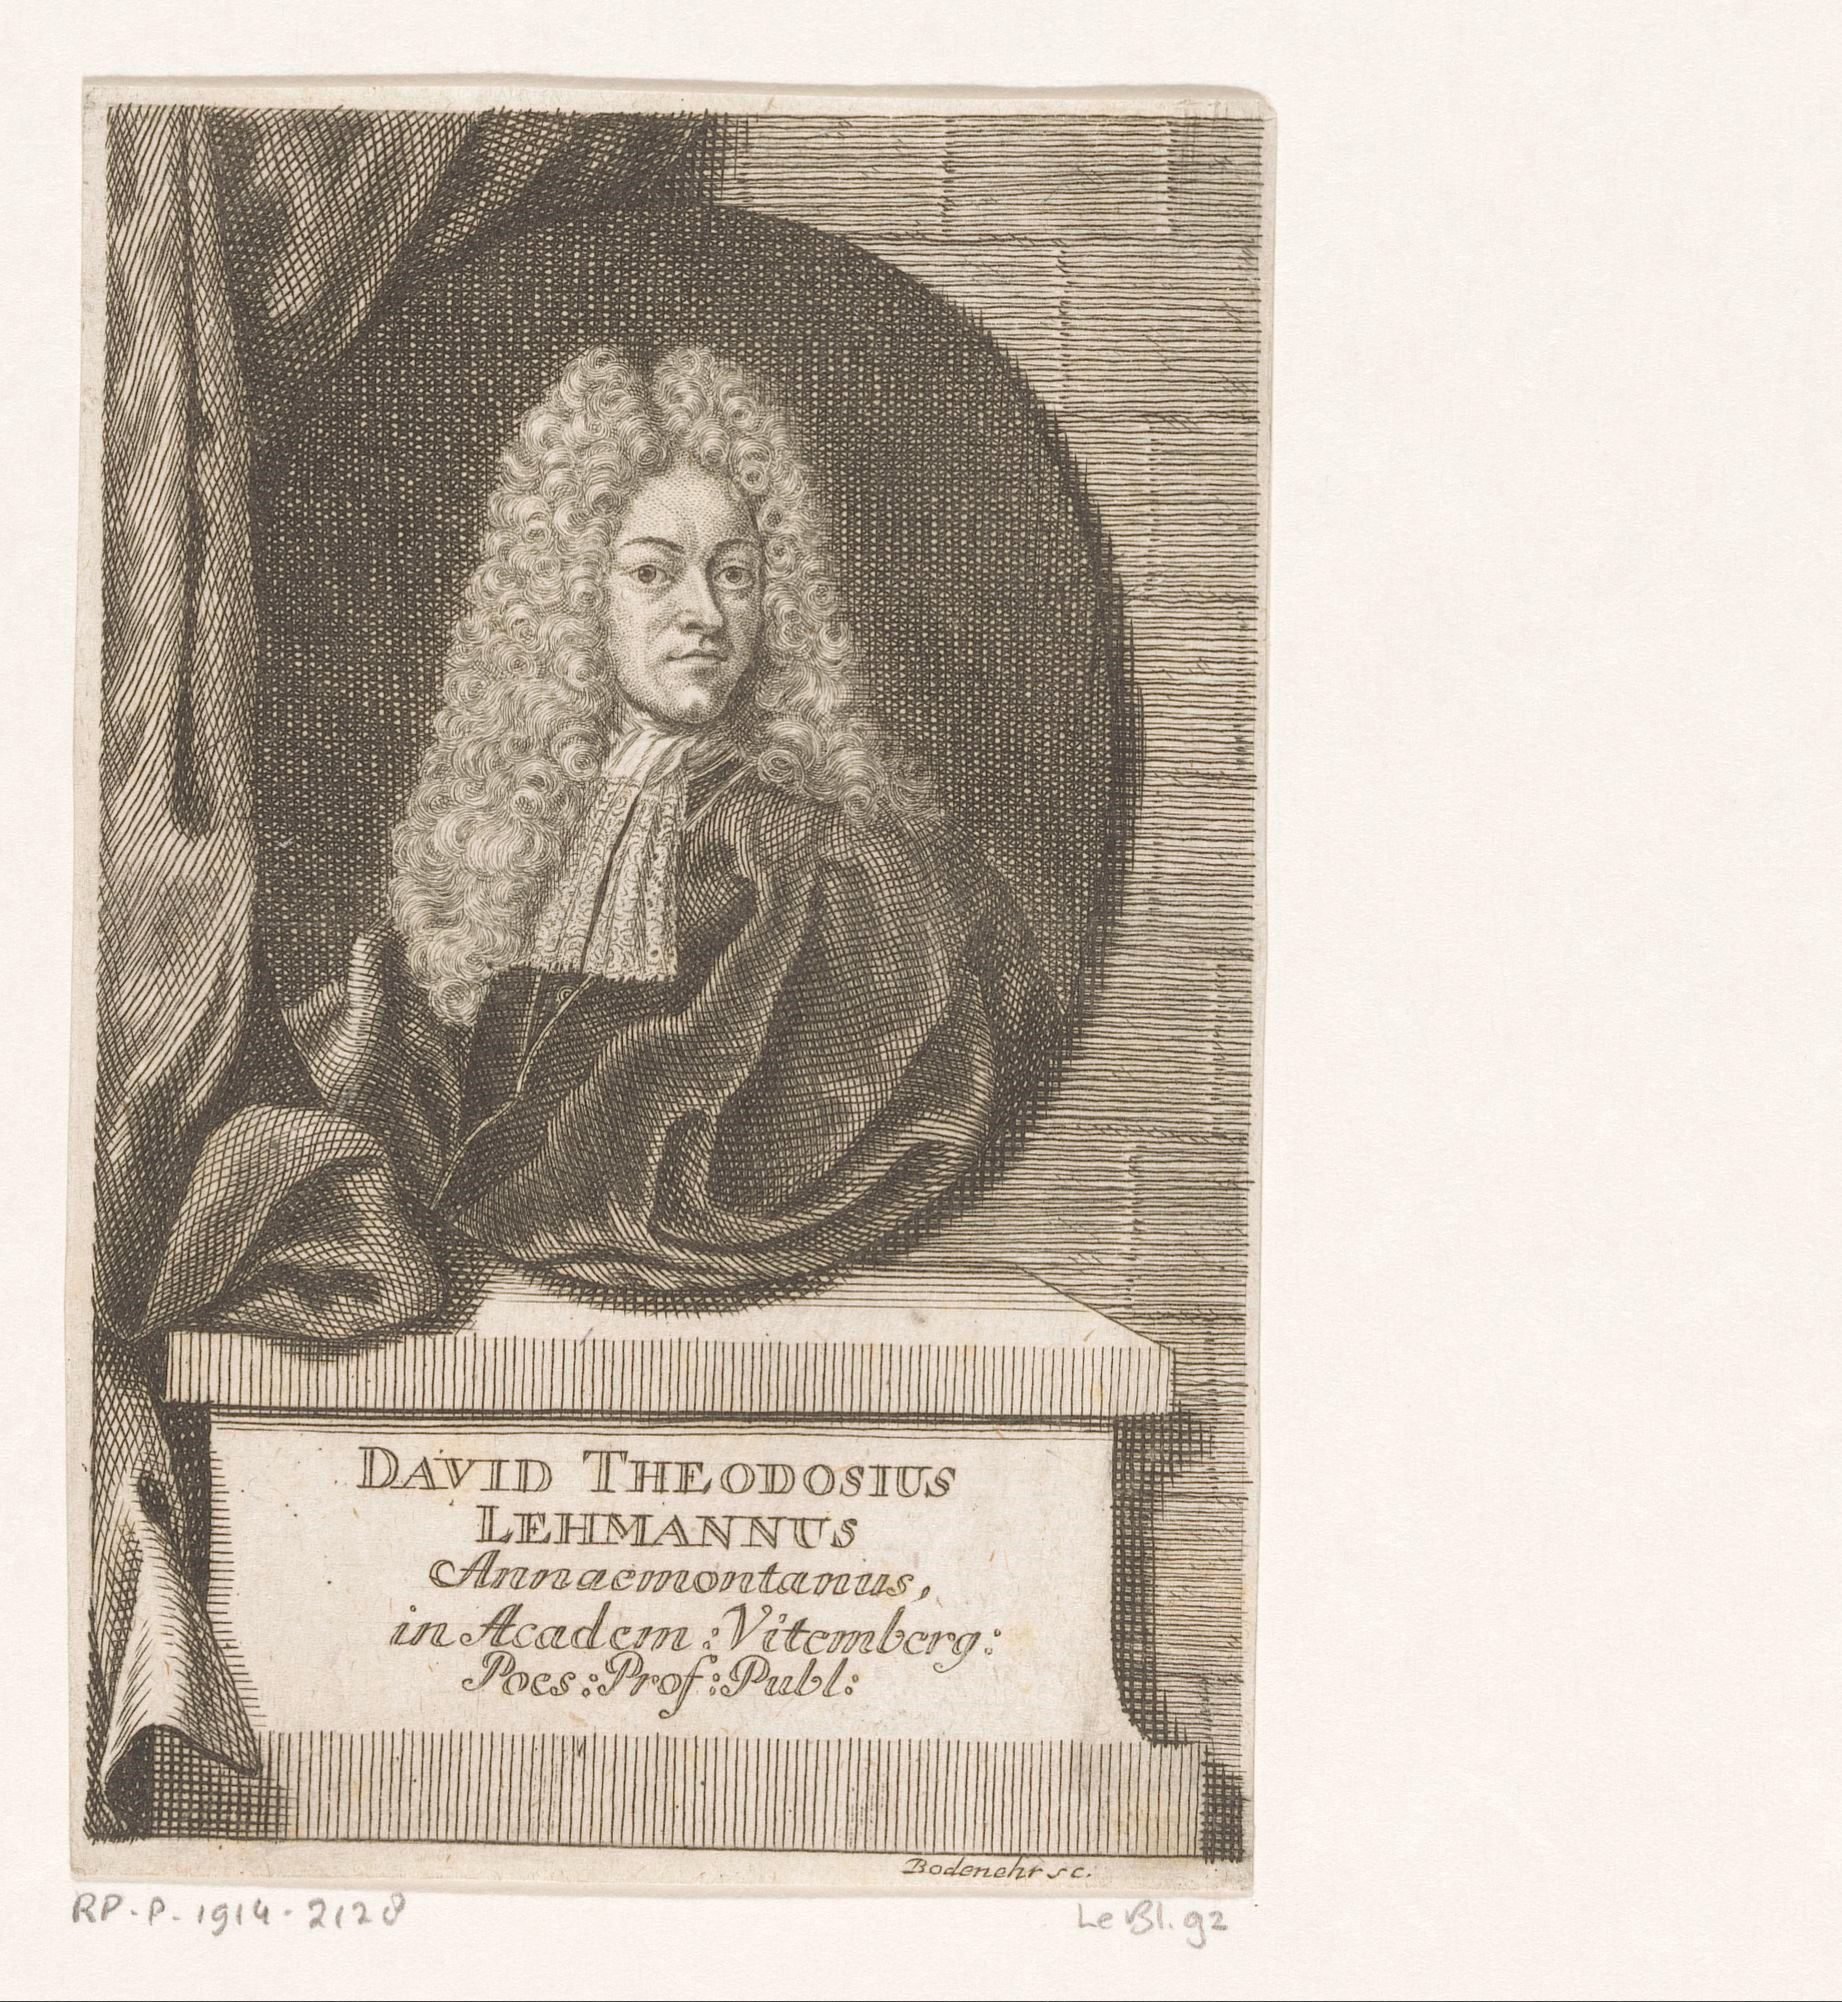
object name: print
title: Portret van David Theodosius Lehmann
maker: moritz bodenehr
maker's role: print maker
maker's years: 1665-1749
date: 1713-1748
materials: paper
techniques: engraving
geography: dresden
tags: historical persons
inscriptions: collector's mark: Lugt 2228